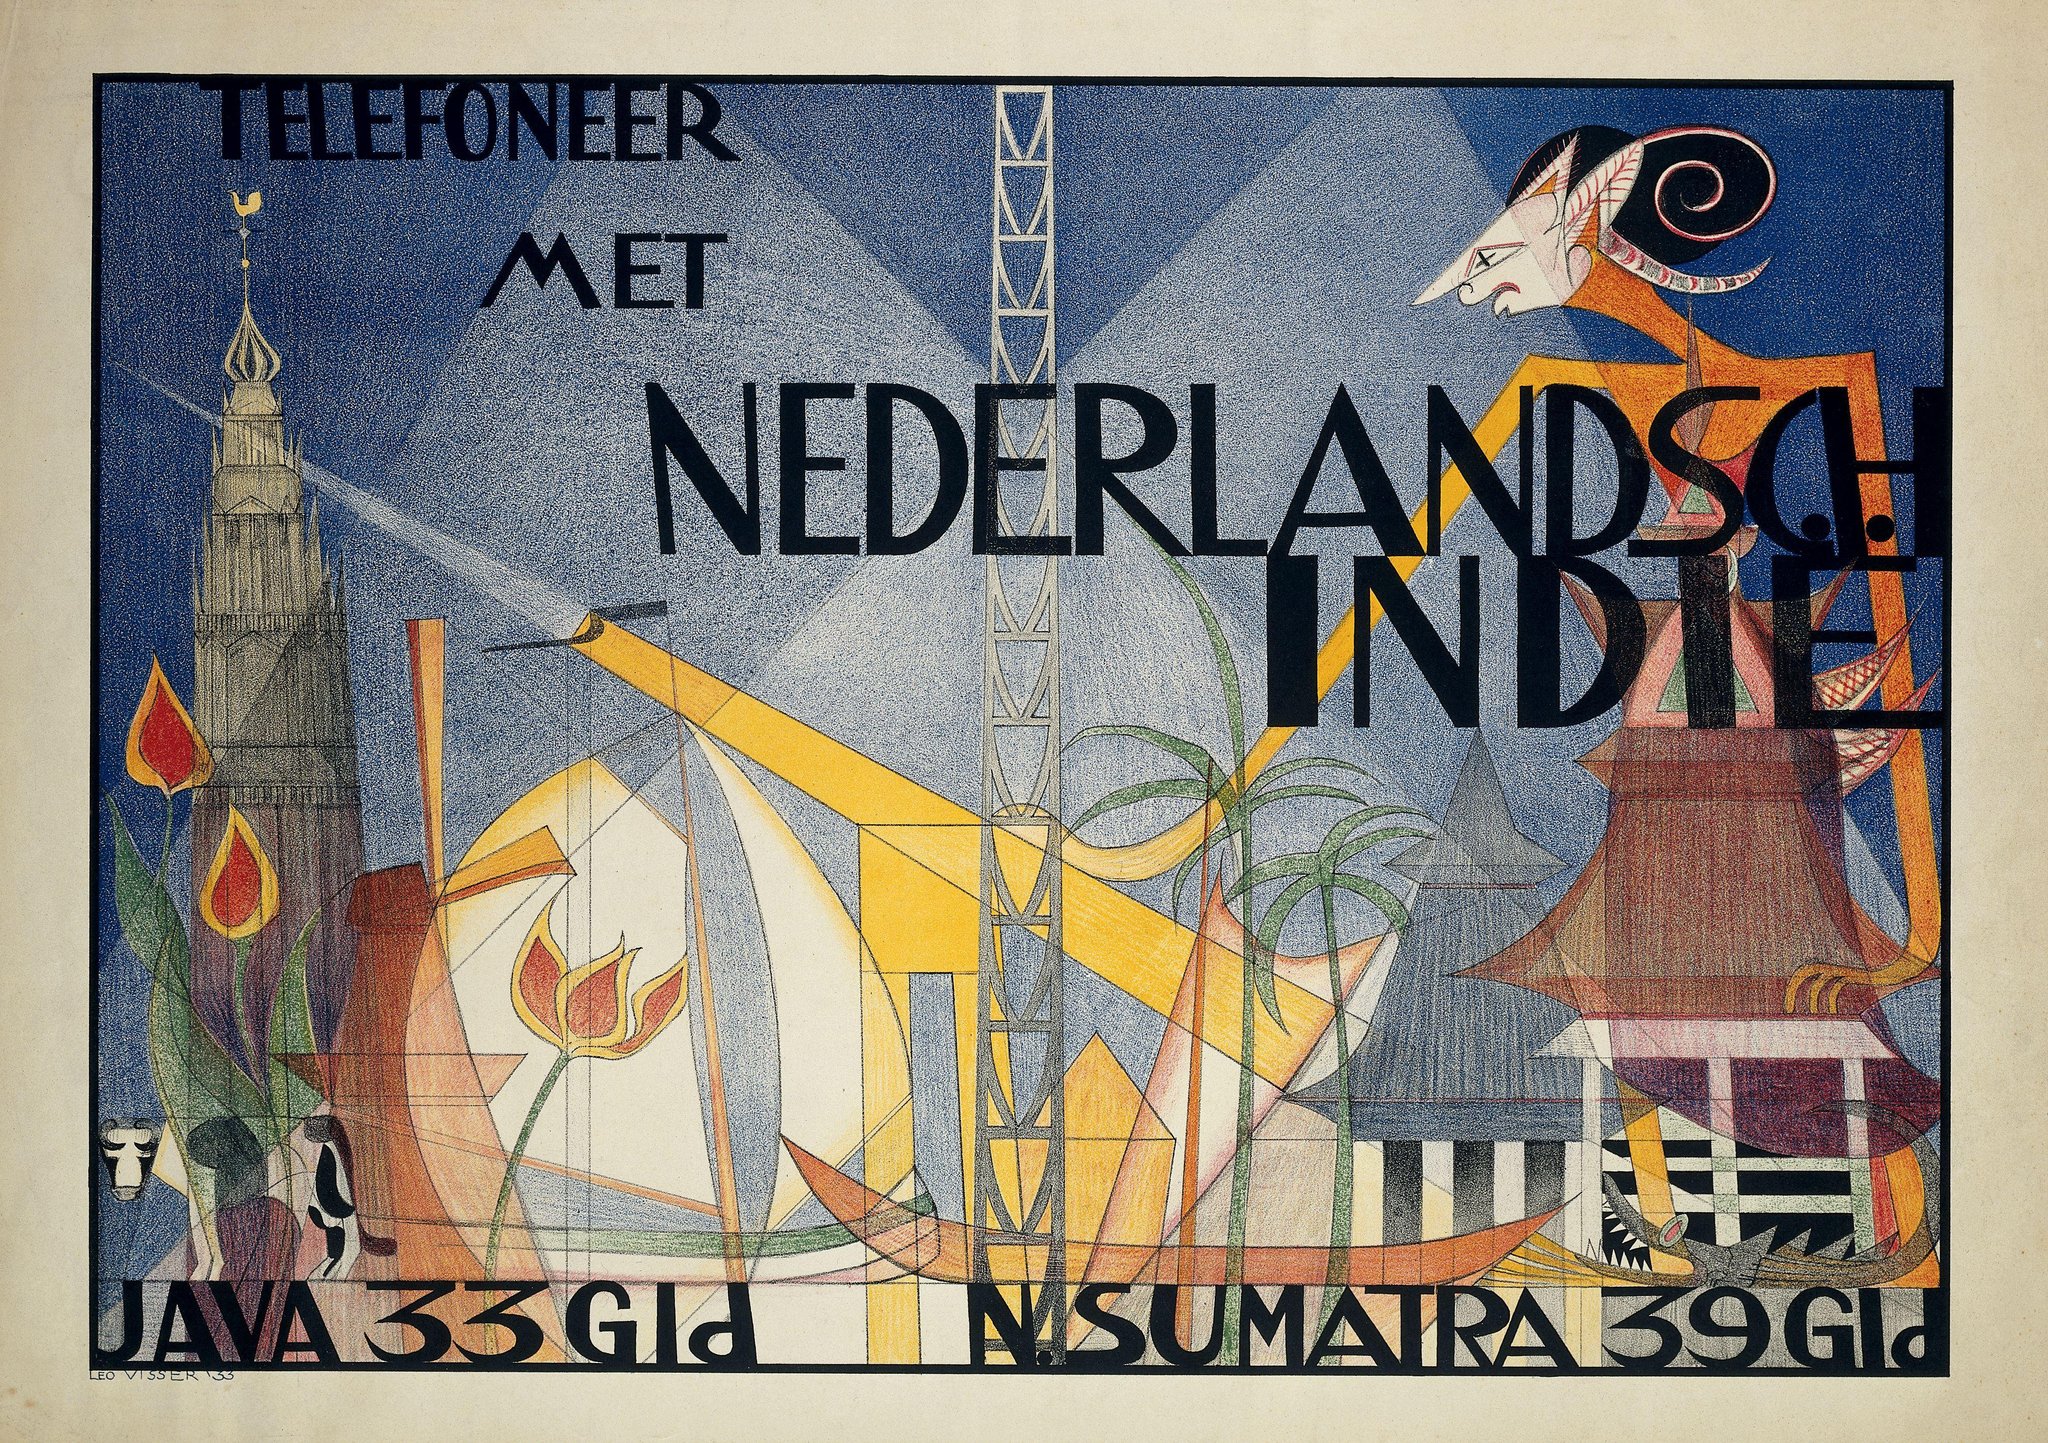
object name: poster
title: Poster Telefoneer met Nederlandsch-Indië (Telephone with the Dutch East Indies)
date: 1933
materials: paper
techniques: lithograph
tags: ships (in general), flowers: tulip, windmill, parts of church exterior and annexes: tower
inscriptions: date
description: Technological inventions rapidly improved communication between the Netherlands and colonial Indonesia. Telephone calls could be made via a direct connection from 1929. This poster is an advertisement for this service. A three-minute call to Java cost 33 guilders (more than a week’s salary for a skilled worker). At the left is typical Dutch imagery, and at the right a shadow puppet, an equally cliché representation of the Dutch East Indies.